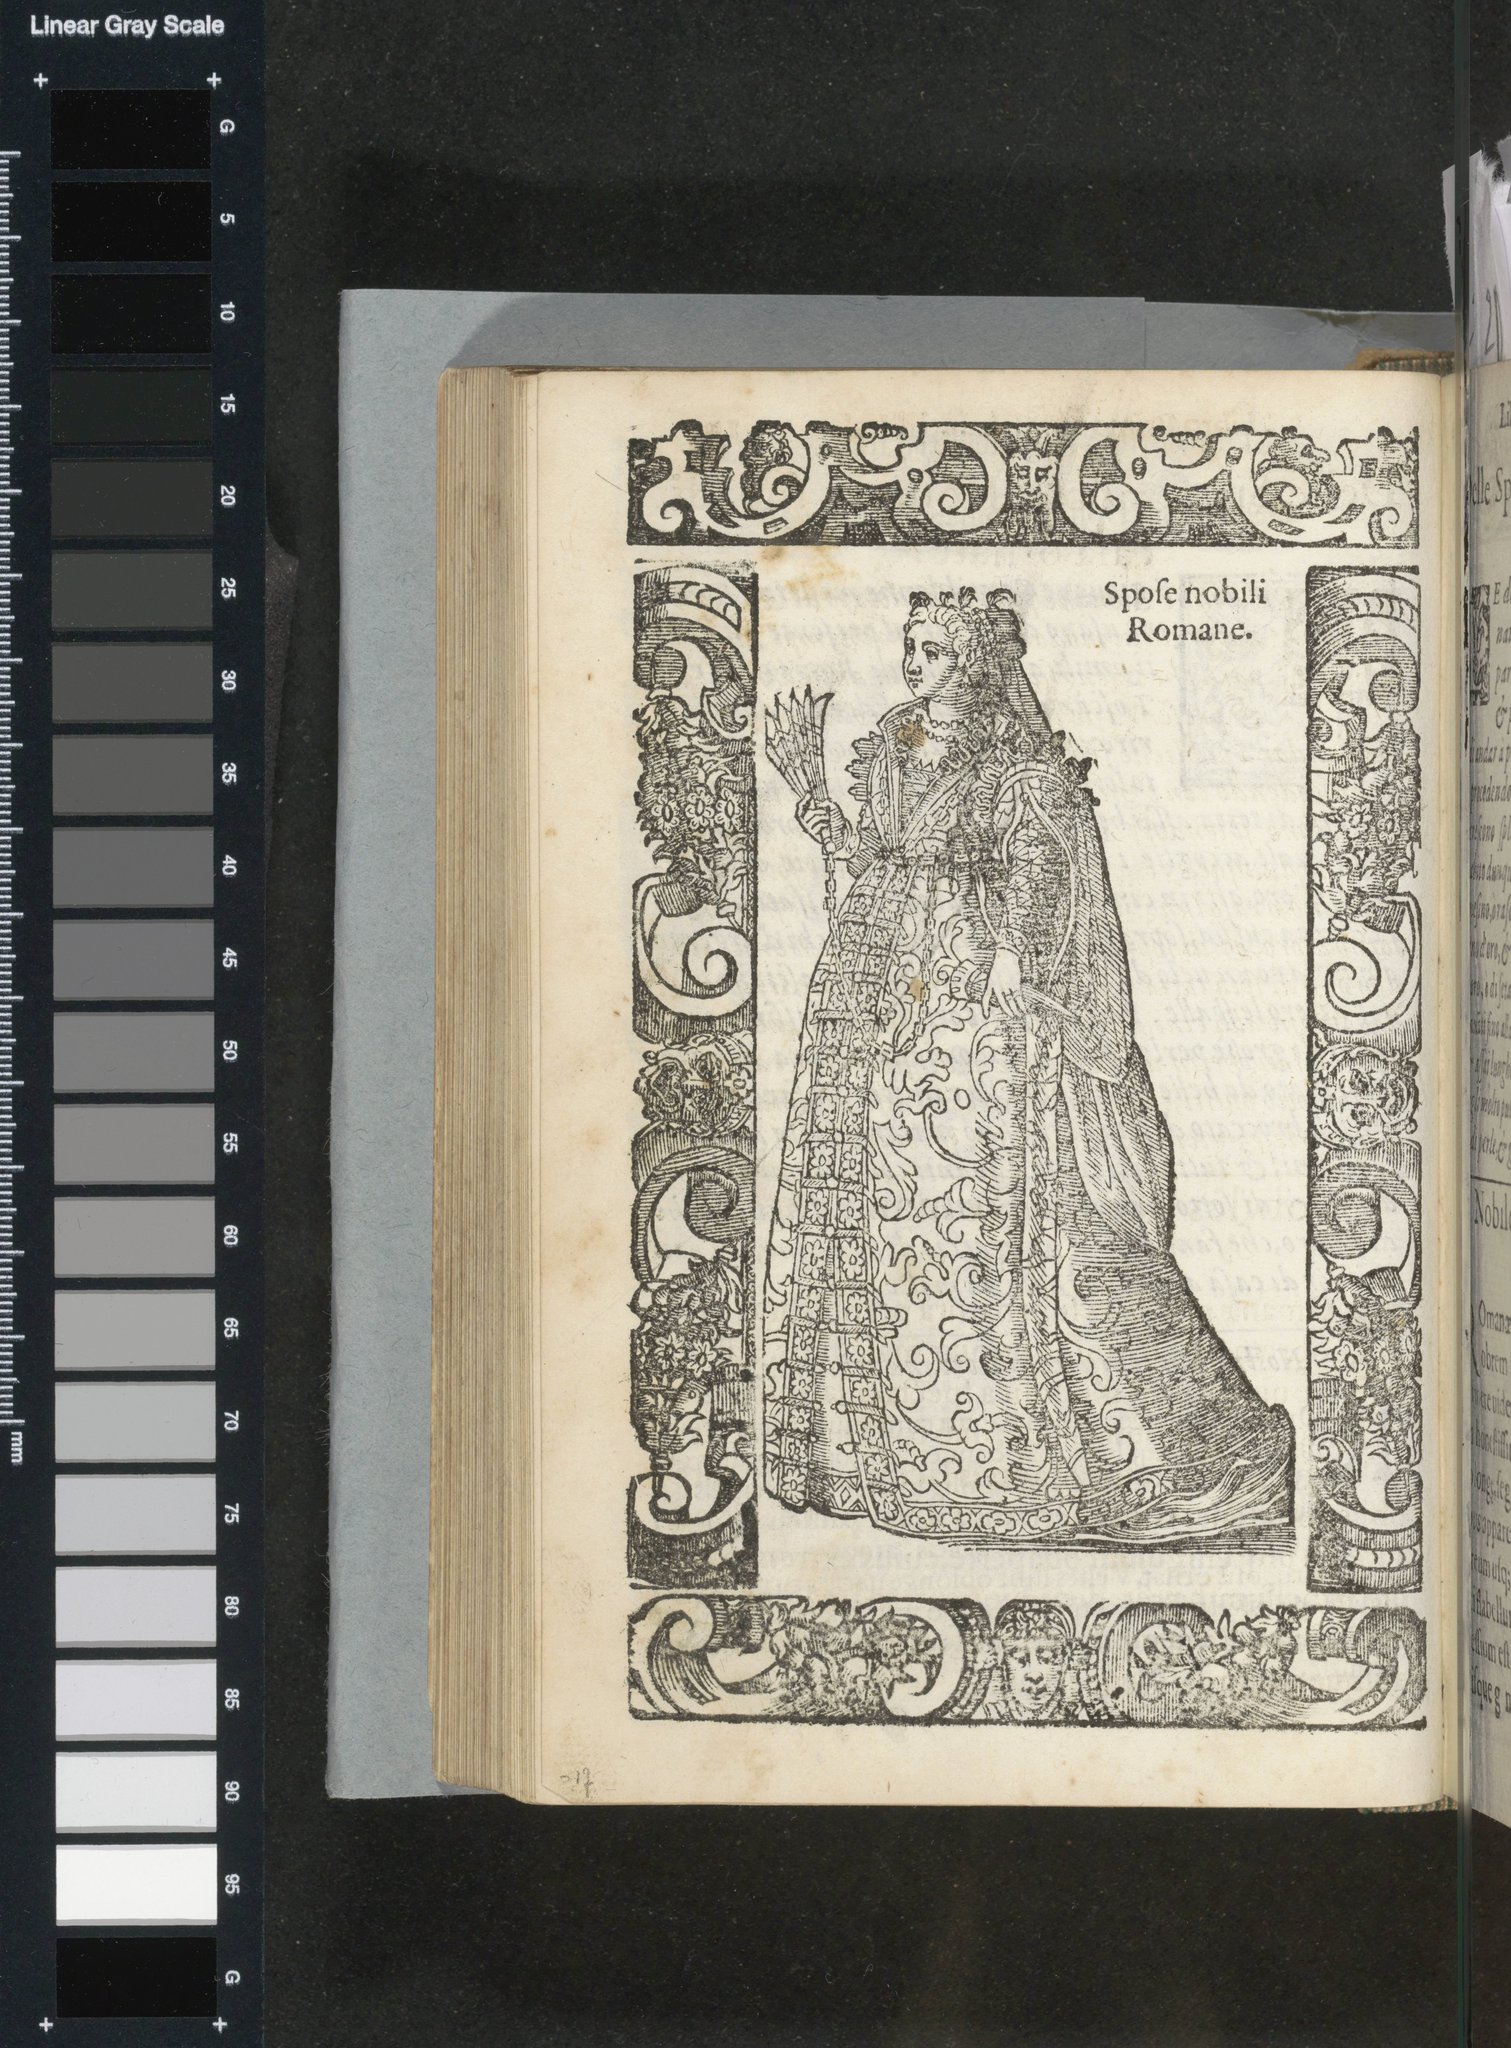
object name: costume print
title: Adellijke bruid uit Rome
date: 1598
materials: paper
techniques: woodcut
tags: ear-rings (+ women's clothes), veil (+ women's clothes), gloves, mittens (short gloves) (+ women's clothes), fashion plates, dress, gown (+ women's clothes), pearl; pearl necklace (+ women's clothes)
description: Bruid uit de Romeinse adel, in formeel kostuum, buitenshuis. Ze is gekleed in een rijk geborduurde ‘sottane’, waarover een overjapon of ‘zimarra’ , van boven tot onder afgezet met een rand met knoopjes, aan de onderkant iets open vallend zodat het onderkleed zichtbaar is. Parelsnoeren om de hals. Zijden sluier op het hoofd. Waaier in de hand. In ornamentrand.